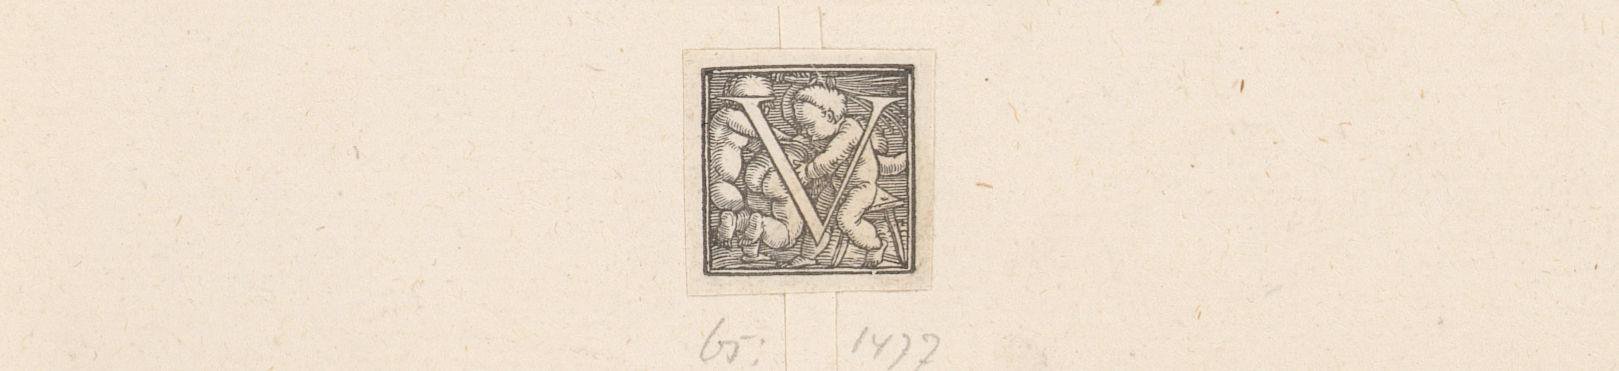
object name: book illustration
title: Initiaal V met kind dat ander kind op de blote billen slaat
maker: hans lützelburger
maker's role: print maker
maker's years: -1526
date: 1522-1526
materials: paper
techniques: woodcut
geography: basel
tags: initial, cupids: 'amores', 'amoretti', 'putti'